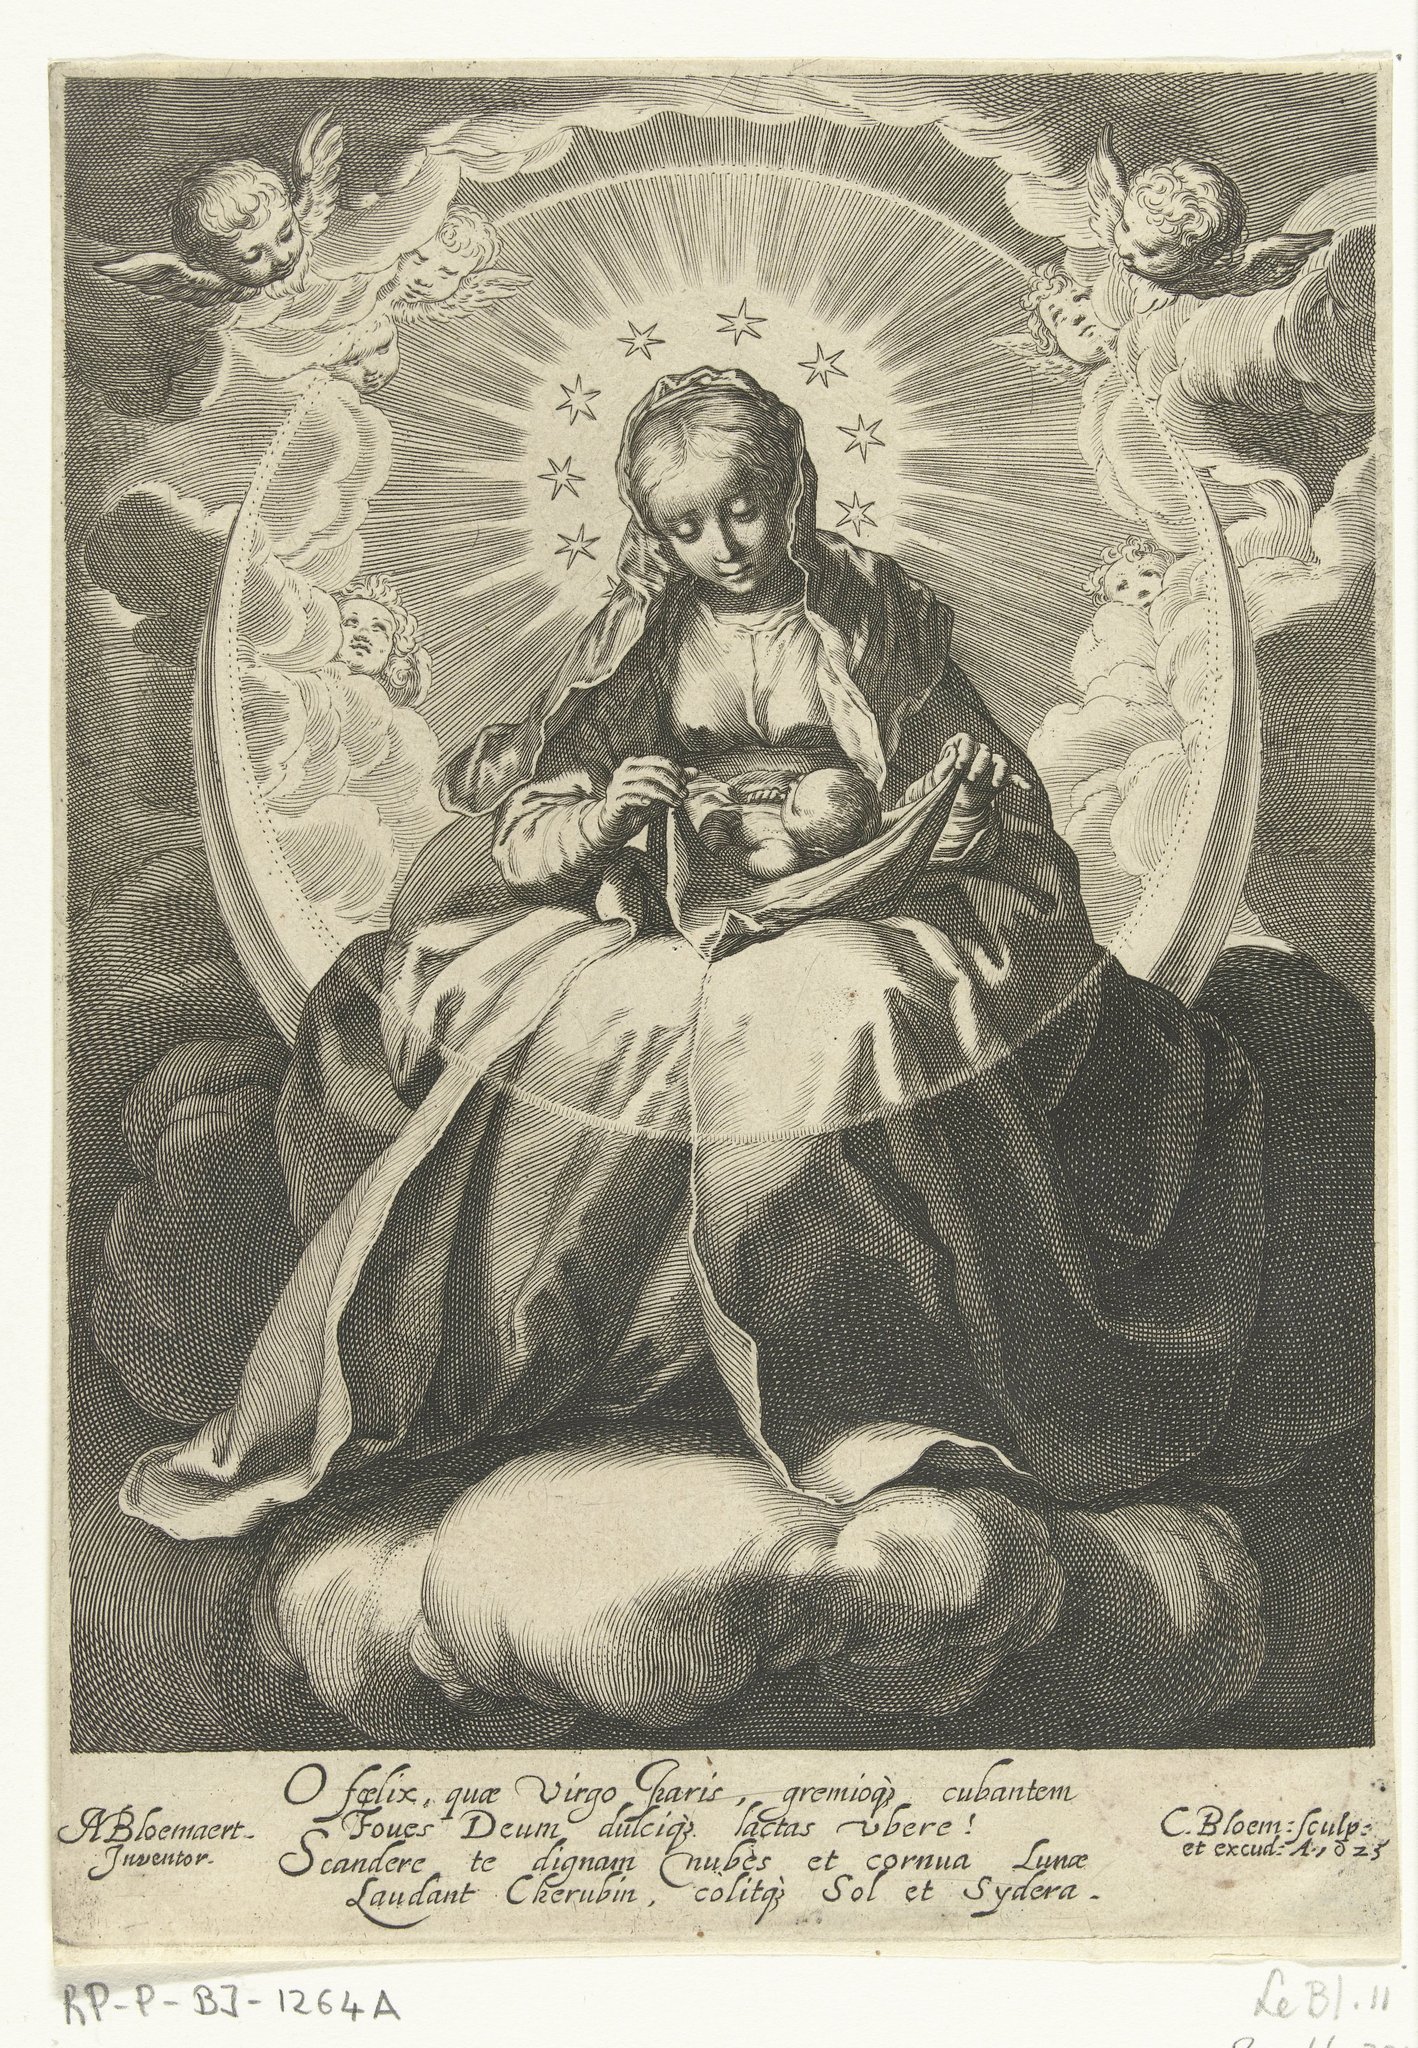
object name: print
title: Madonna zittend op de maansikkel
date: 1625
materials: paper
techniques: engraving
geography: utrecht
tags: madonna on the crescent of the moon (sometimes called queen of heaven) (in mandorla)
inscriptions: collector's mark: Lugt 240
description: Maria met het Kind op haar schoot, zittend op de maansikkel in de wolken, een mandorla om haar hoofd. Zeven engeltjes bewegen zich rond de mandorla.